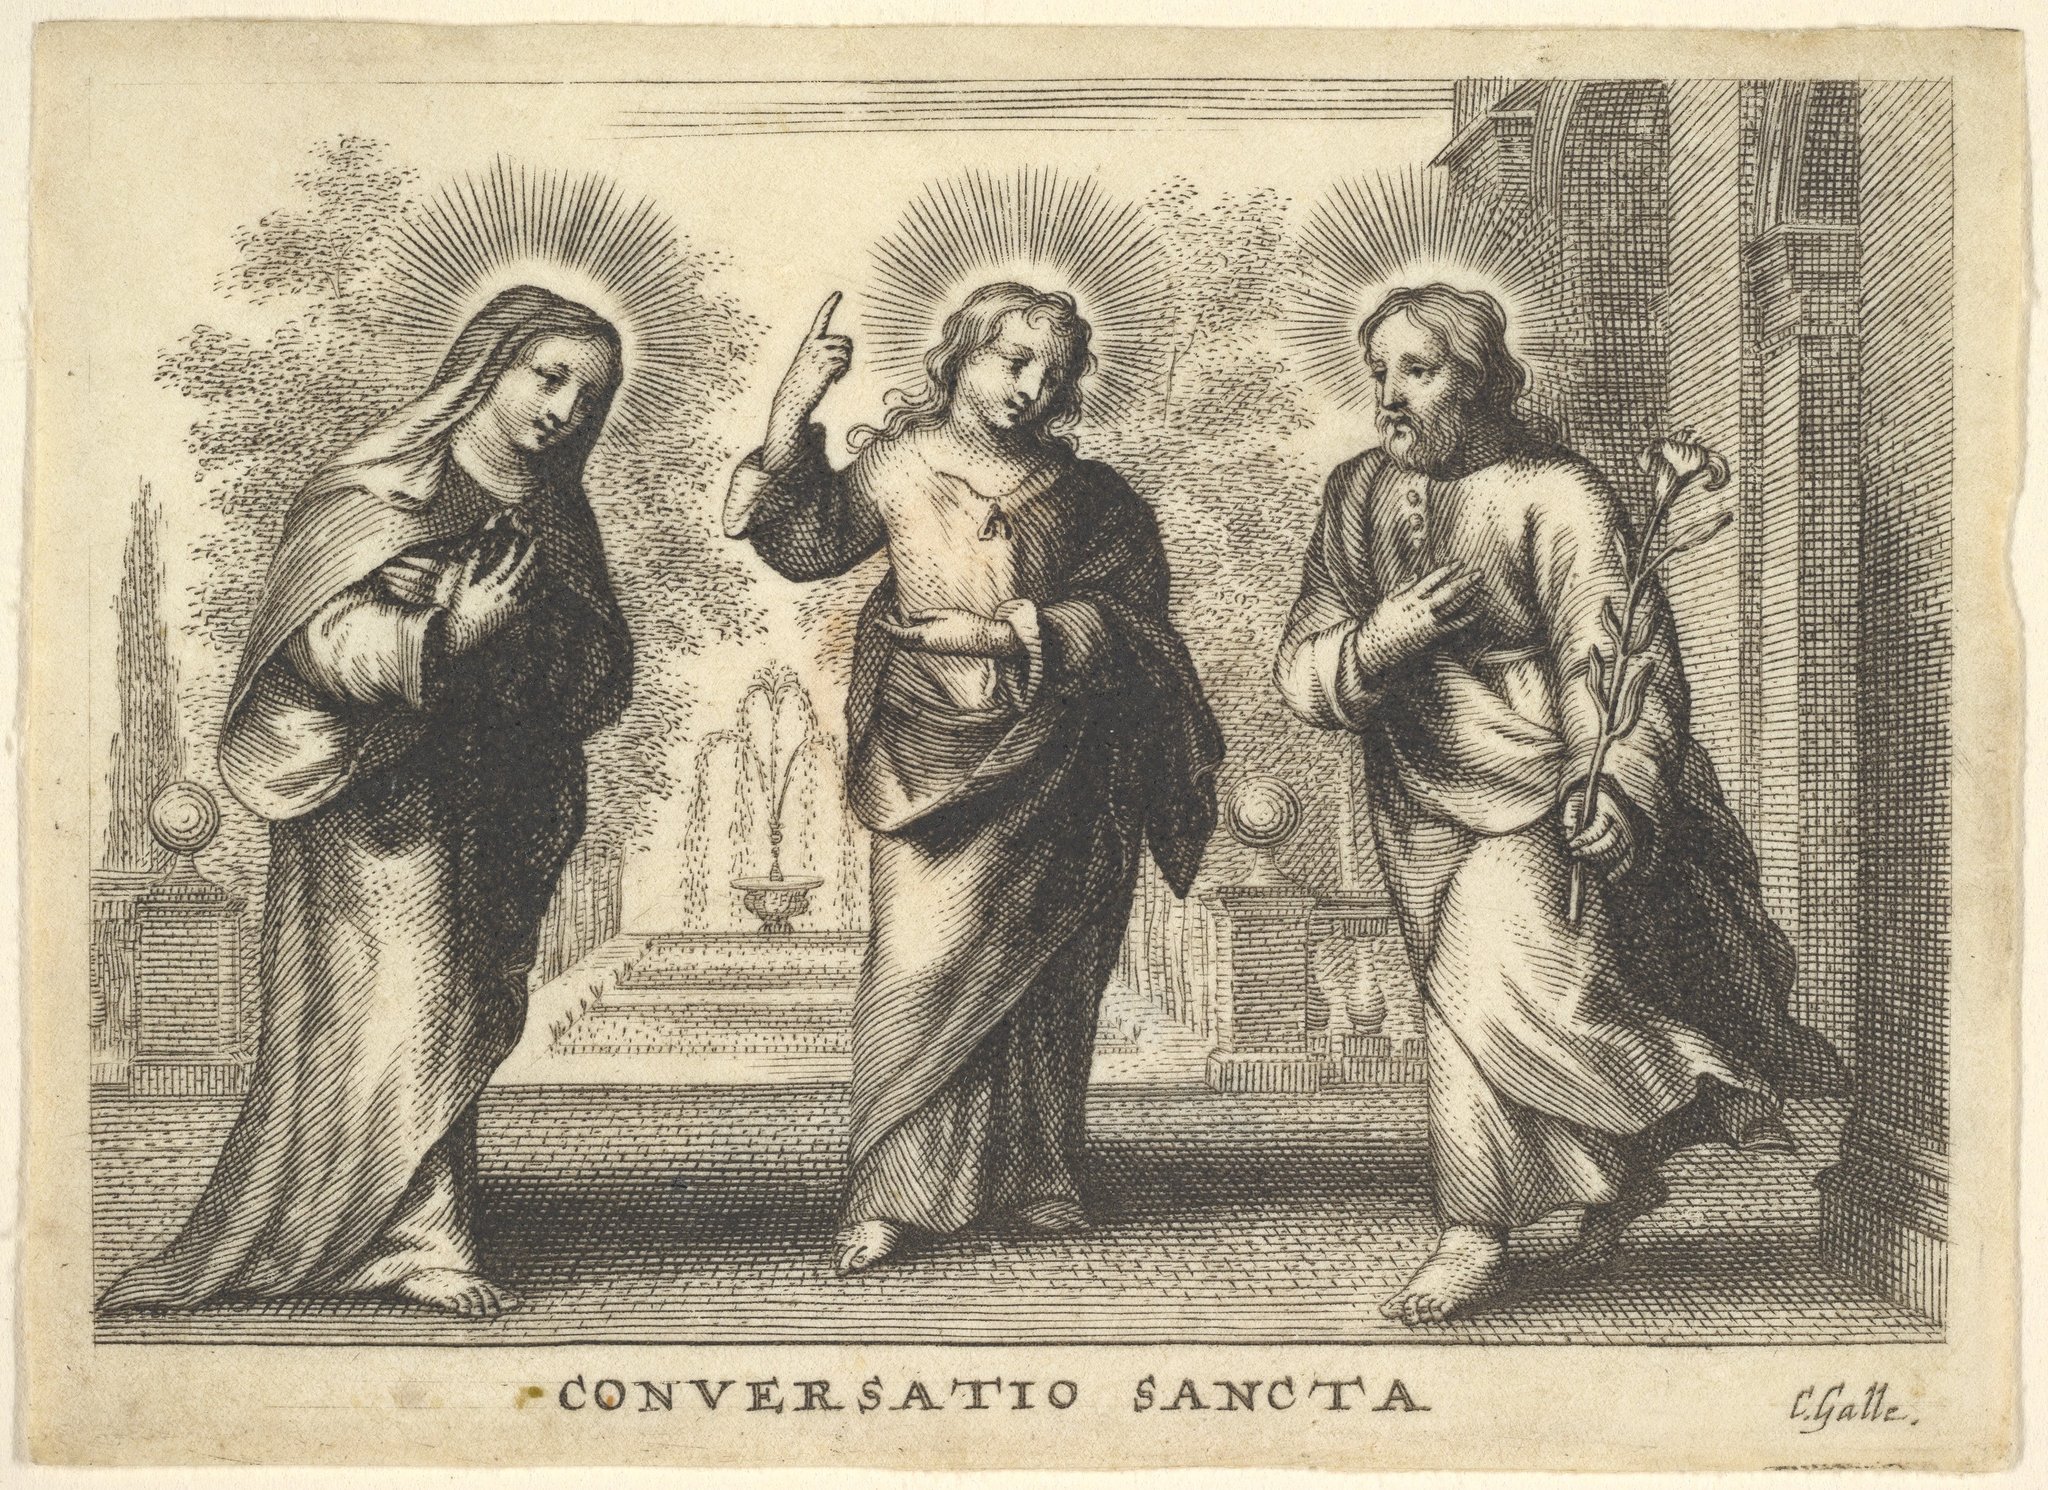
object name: print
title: Conversatio Sancta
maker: cornelis galle (ii)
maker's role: artist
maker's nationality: flemish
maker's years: 1615-1678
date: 1638-1678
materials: parchment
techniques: engraving, printing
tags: saints